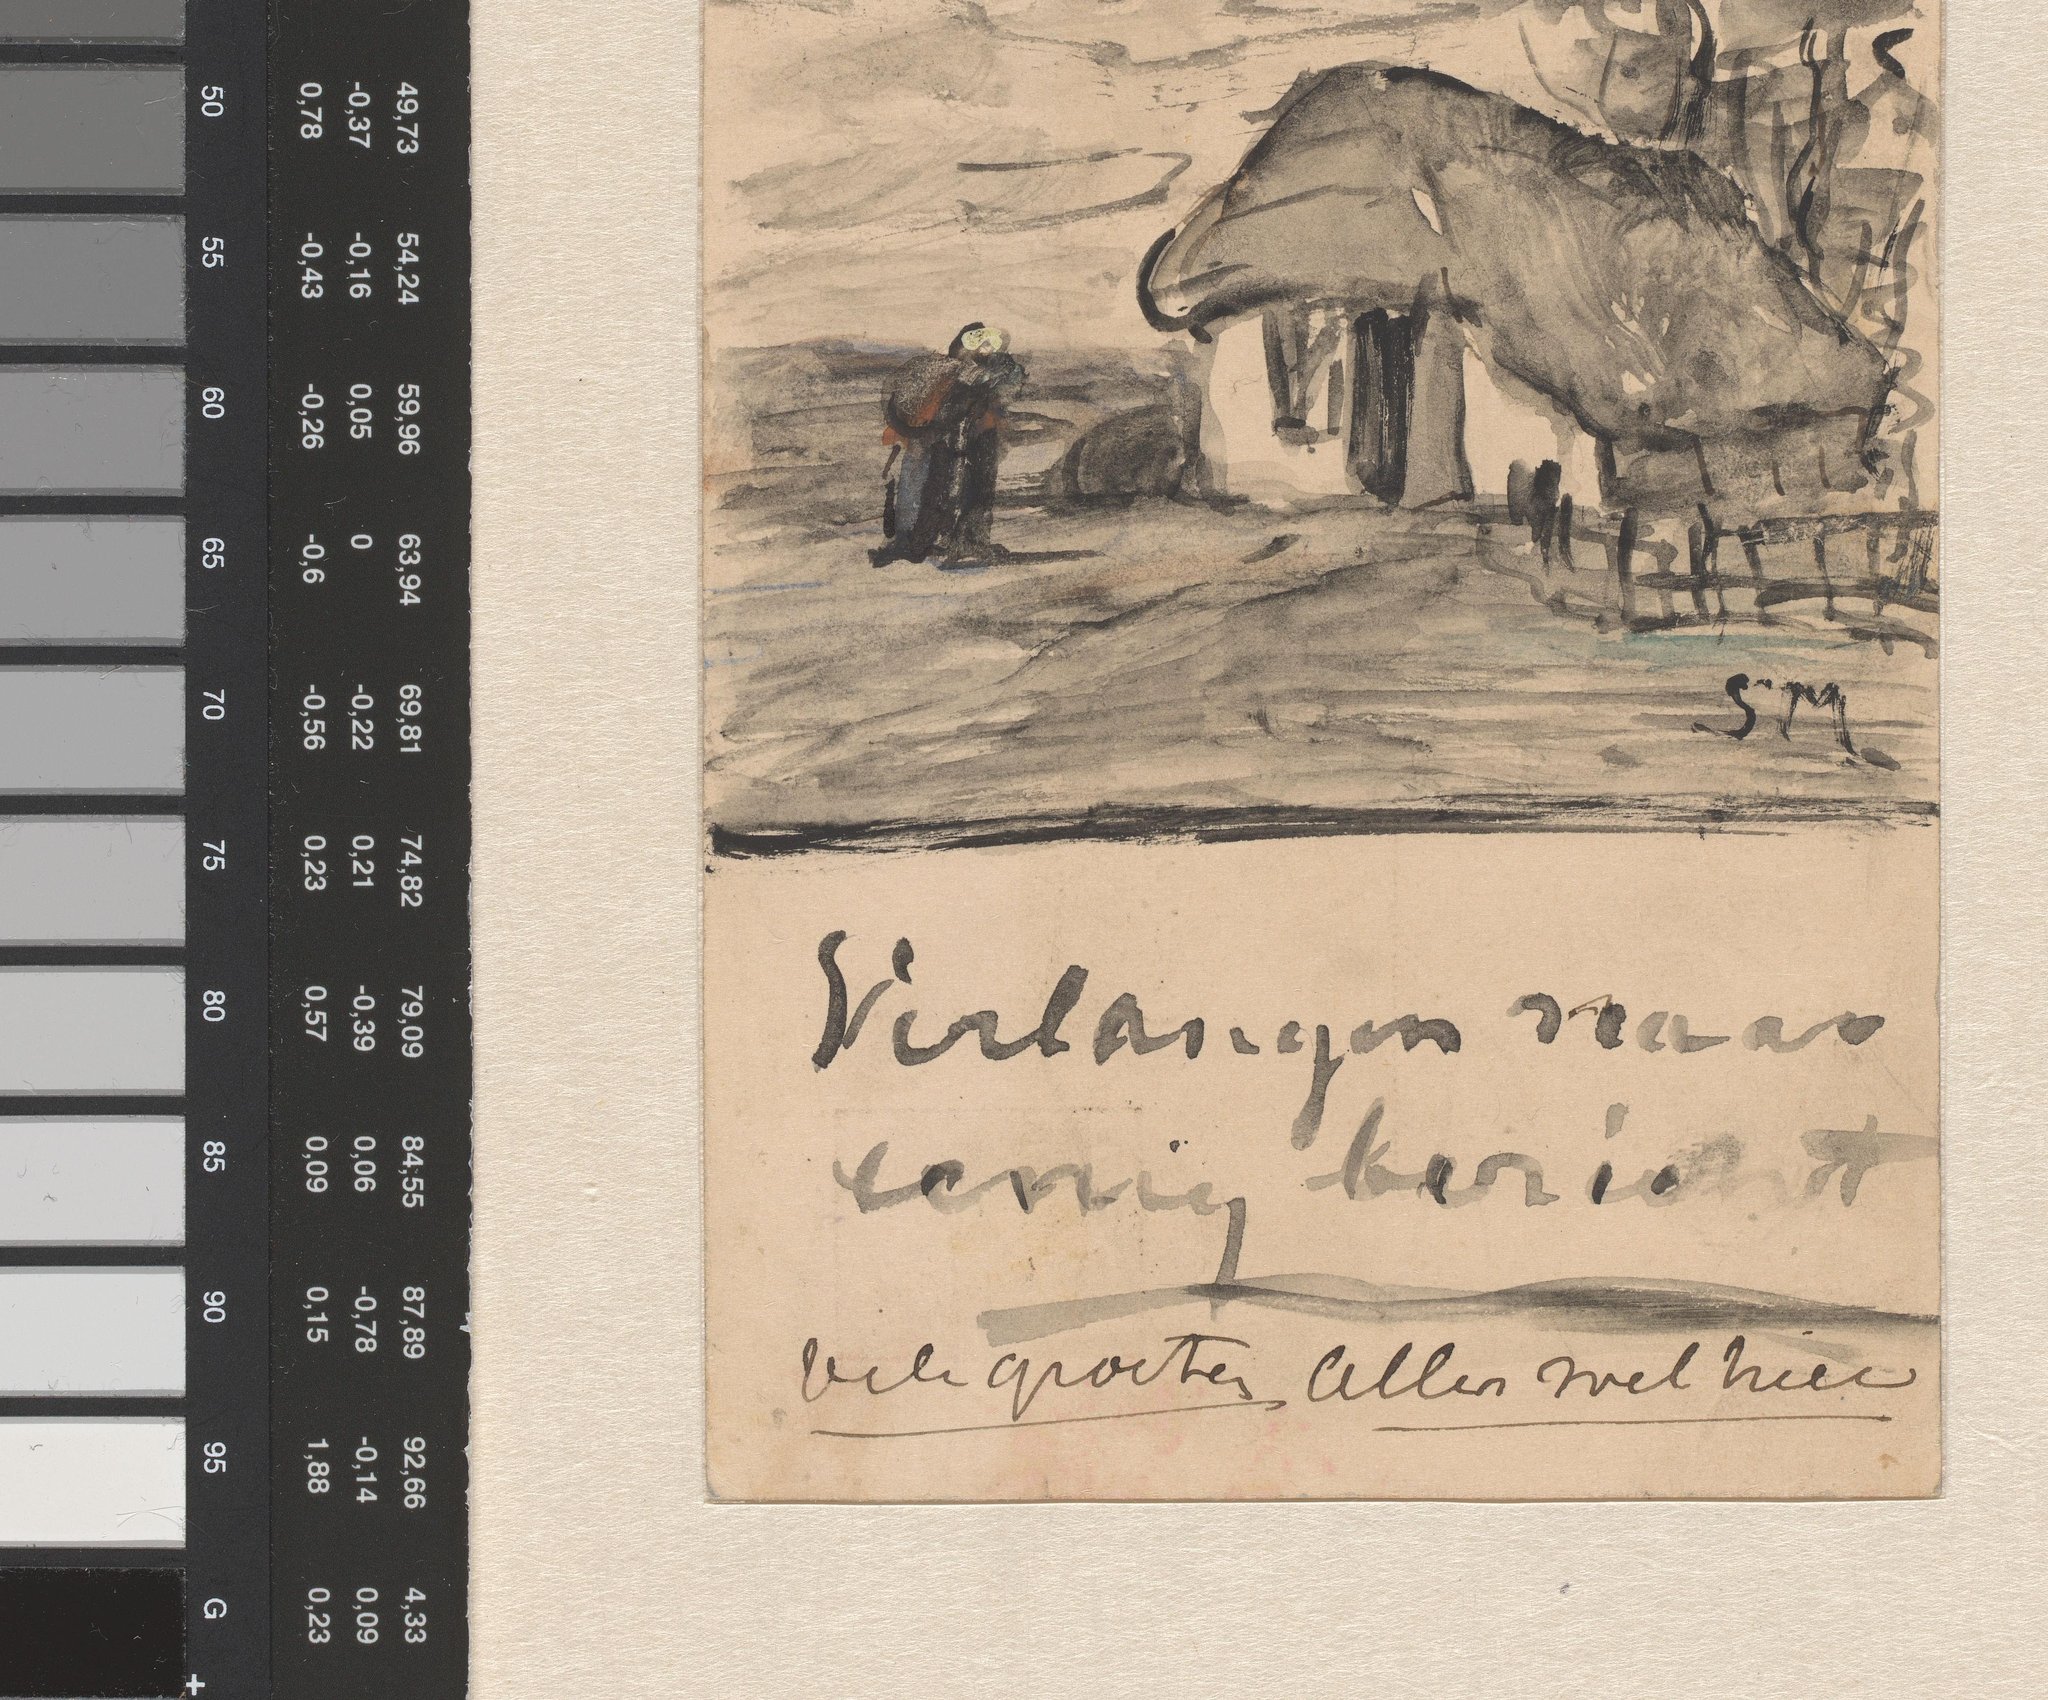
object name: drawing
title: Hut op de heide, met figuur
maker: sientje mesdag-van houten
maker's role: draughtsman, painter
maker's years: 1834-1909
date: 1901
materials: cardboard, paint, ink, watercolor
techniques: brush, pen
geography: netherlands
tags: utrecht, draughtsman, johanna behrend-croiset van der kop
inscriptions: signature: ‘S.M’, inscription: ‘Verlangen naar / terug bericht / Vele groeten. Alles wel hier’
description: Betekende briefkaart Johanna Behrend-Croiset van der Kop in Londen